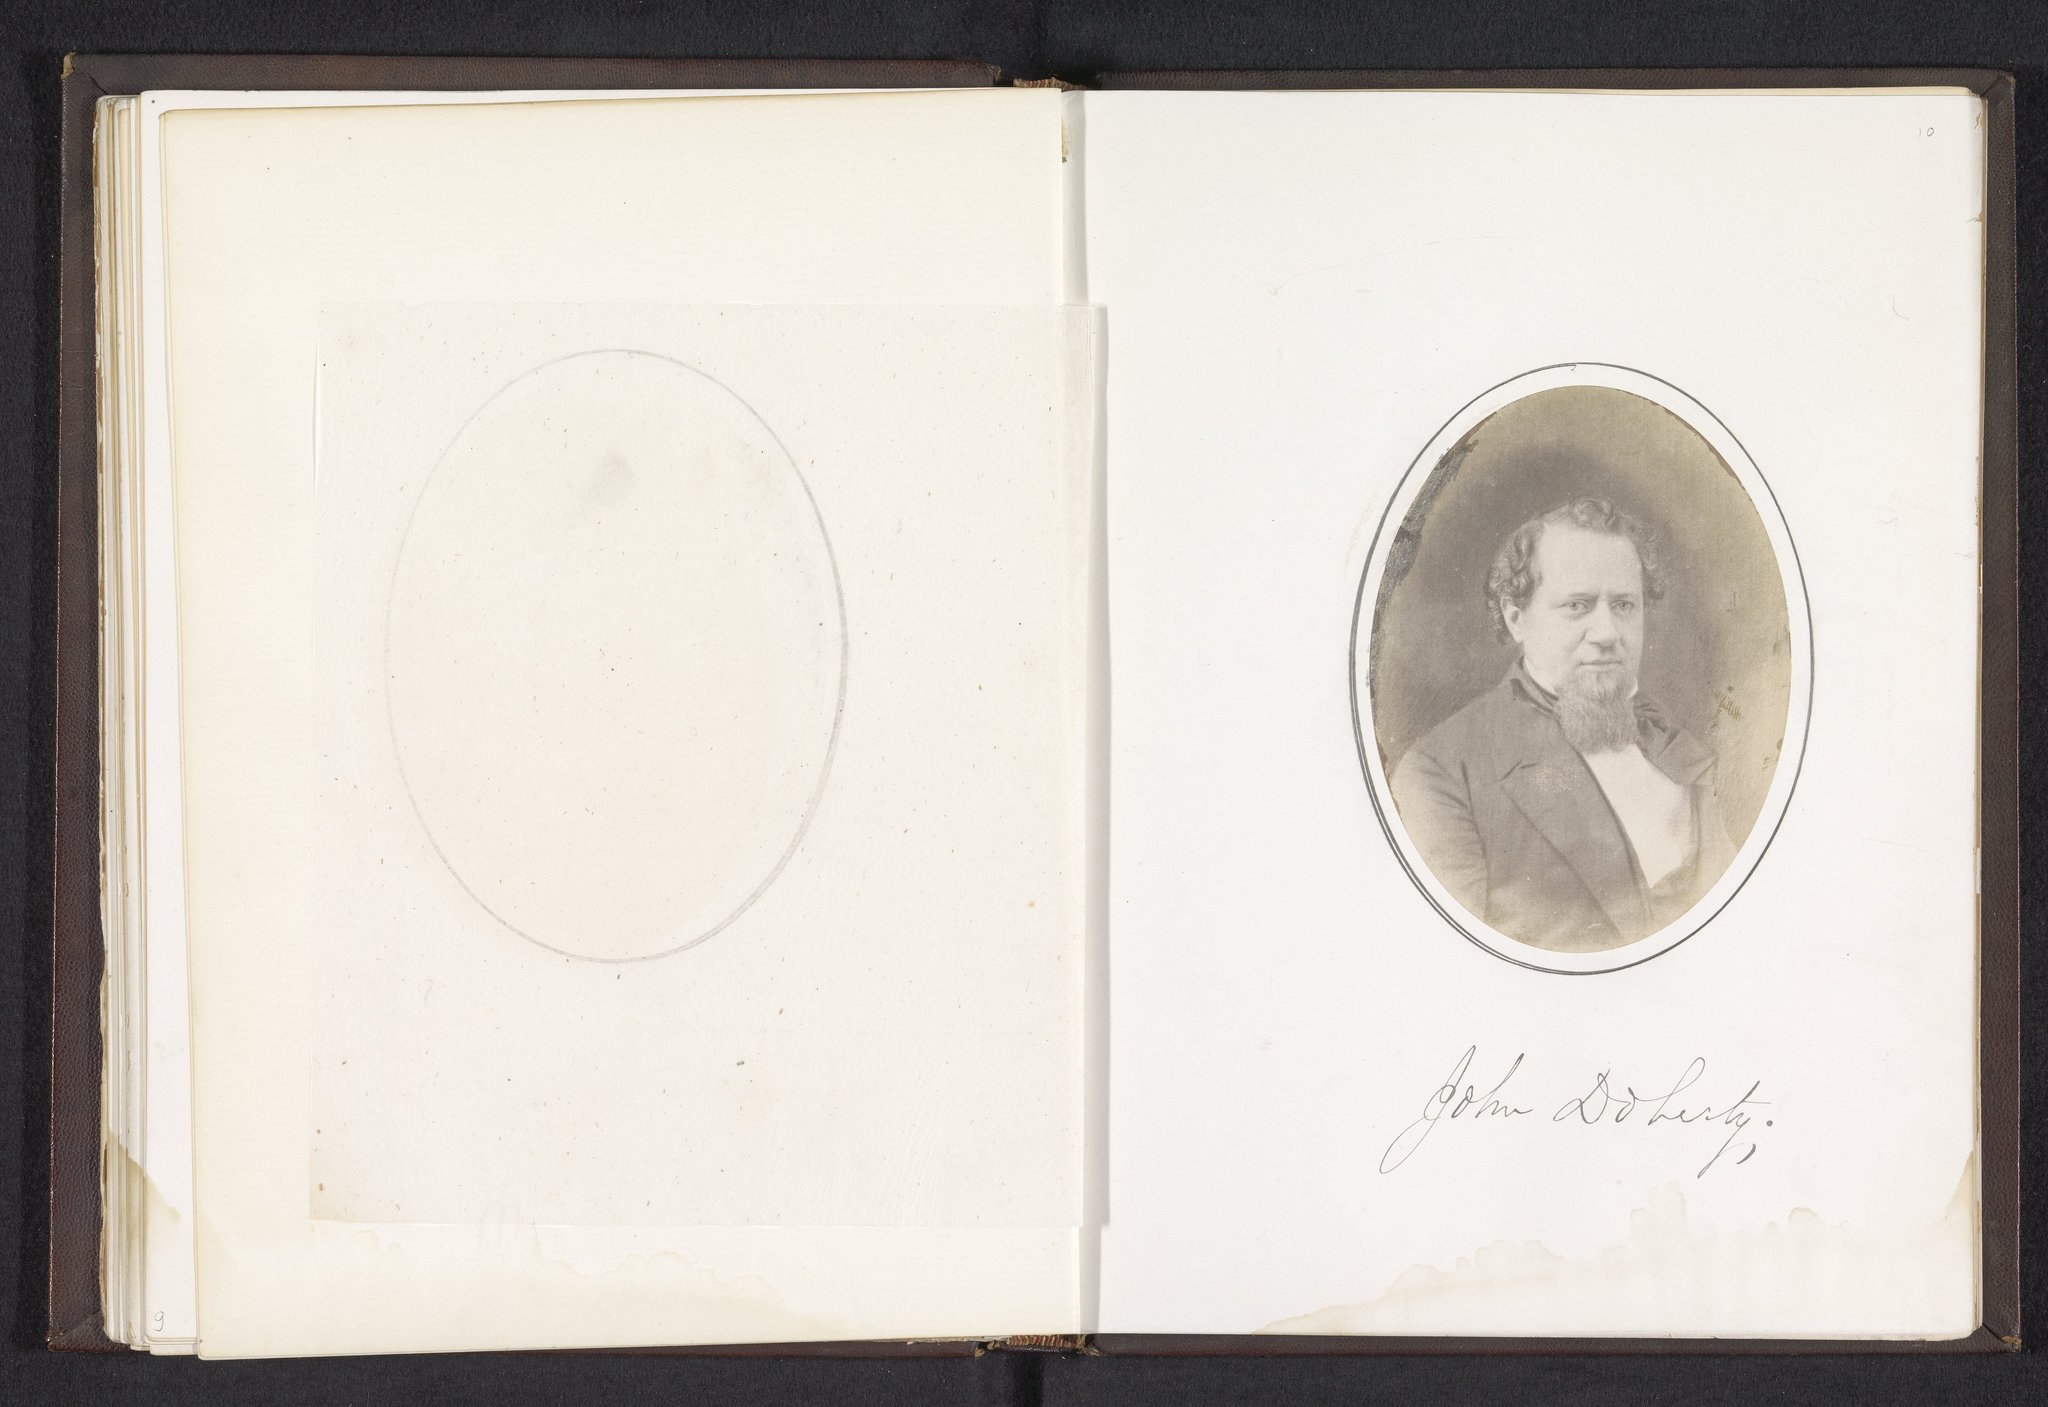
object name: page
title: Portret van Senaatslid John Doherty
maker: d.t.t. davie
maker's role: publisher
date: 1858-1859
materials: photographic support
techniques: salted paper print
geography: new york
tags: politician, e.g. party leader, upper house, senate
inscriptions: inscription: ‘John Doherty;’